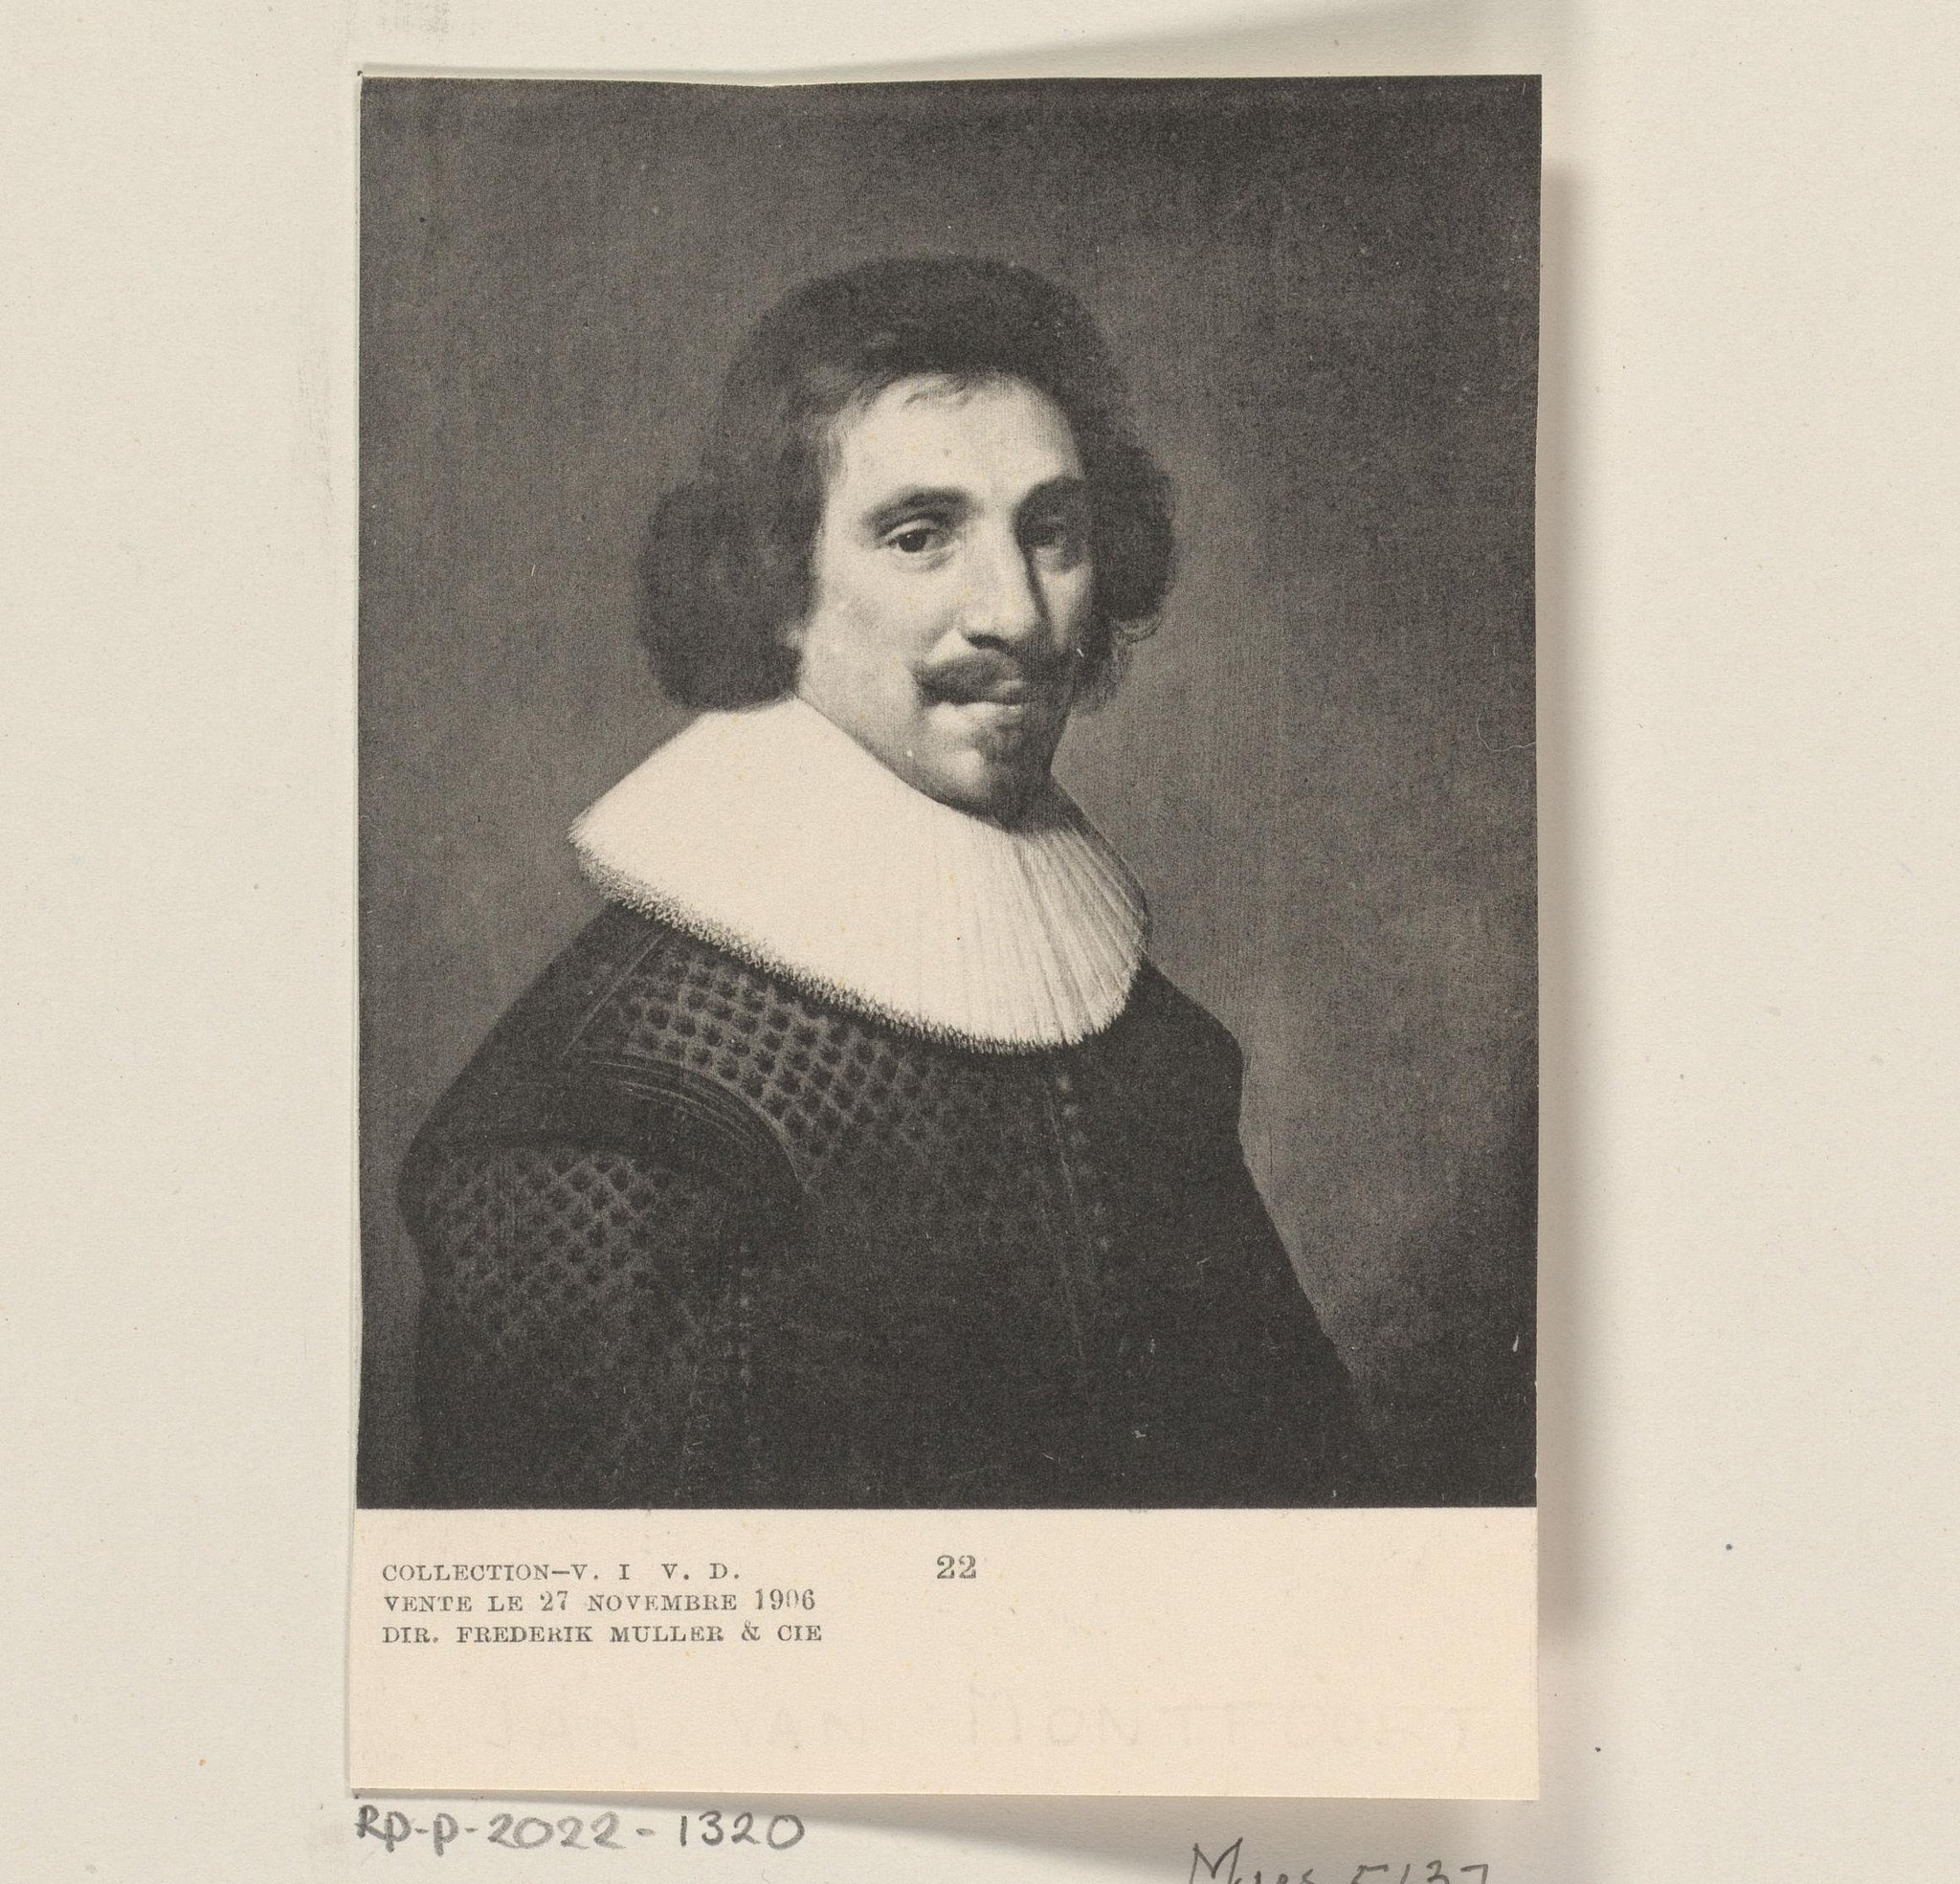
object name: photomechanical print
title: Portret van Jan van Montfort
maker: Anonymous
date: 1905-1906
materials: paper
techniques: photograph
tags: brussels, historical persons, nobility and patriciate; chivalry, knighthood